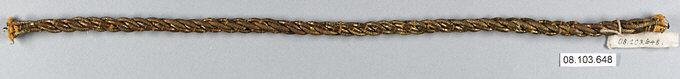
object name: cord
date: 1801-1900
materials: metal thread